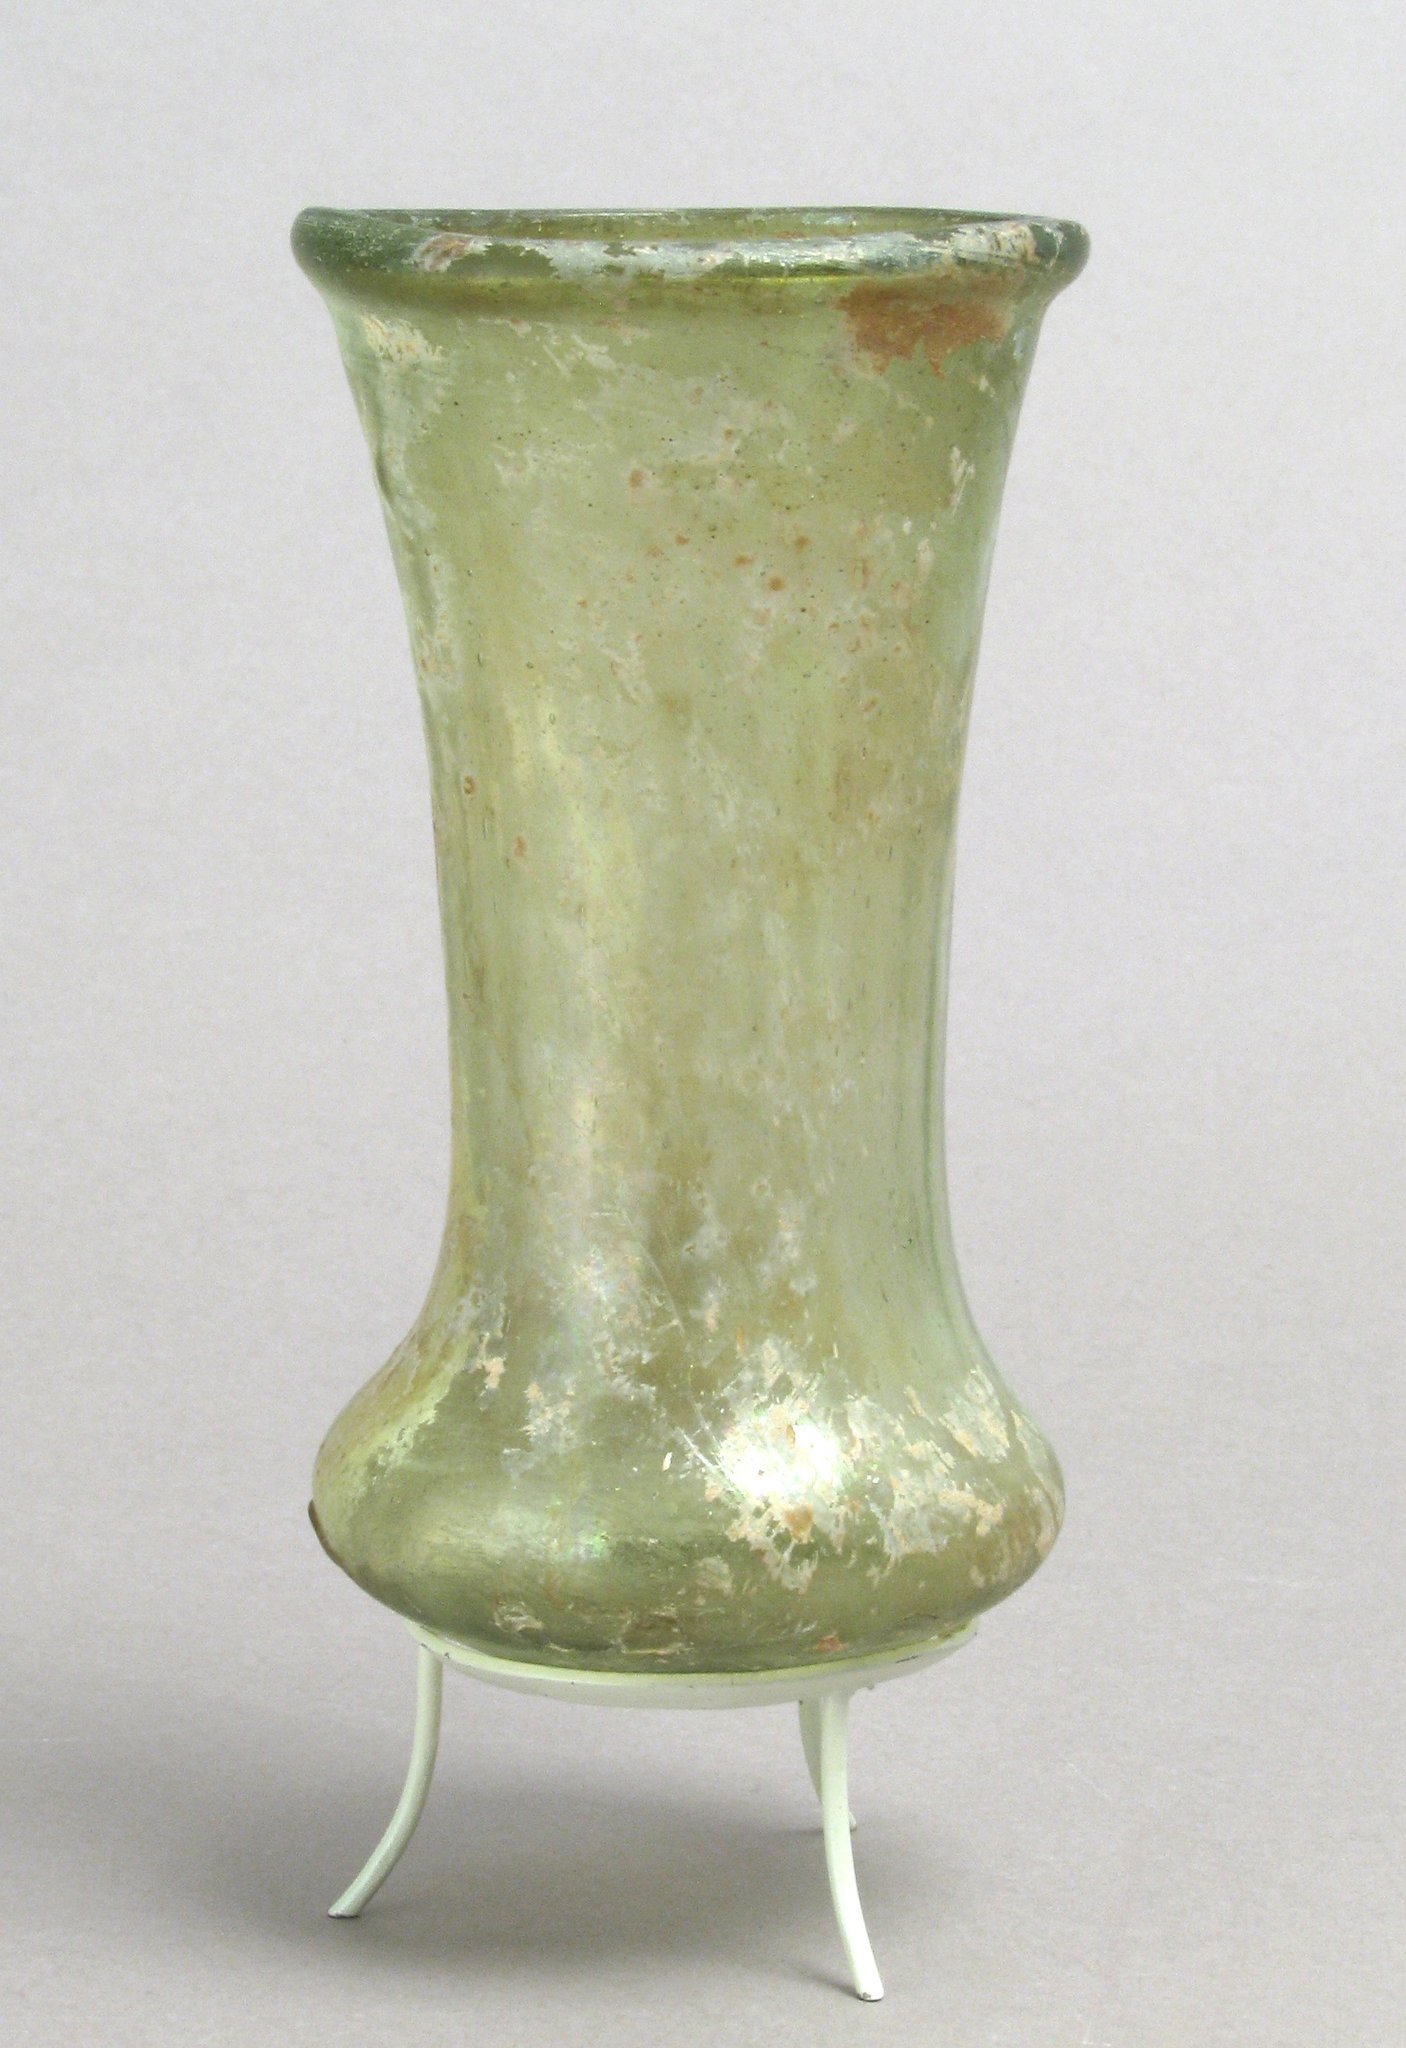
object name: beaker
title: Bell Beaker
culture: frankish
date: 501-700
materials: glass